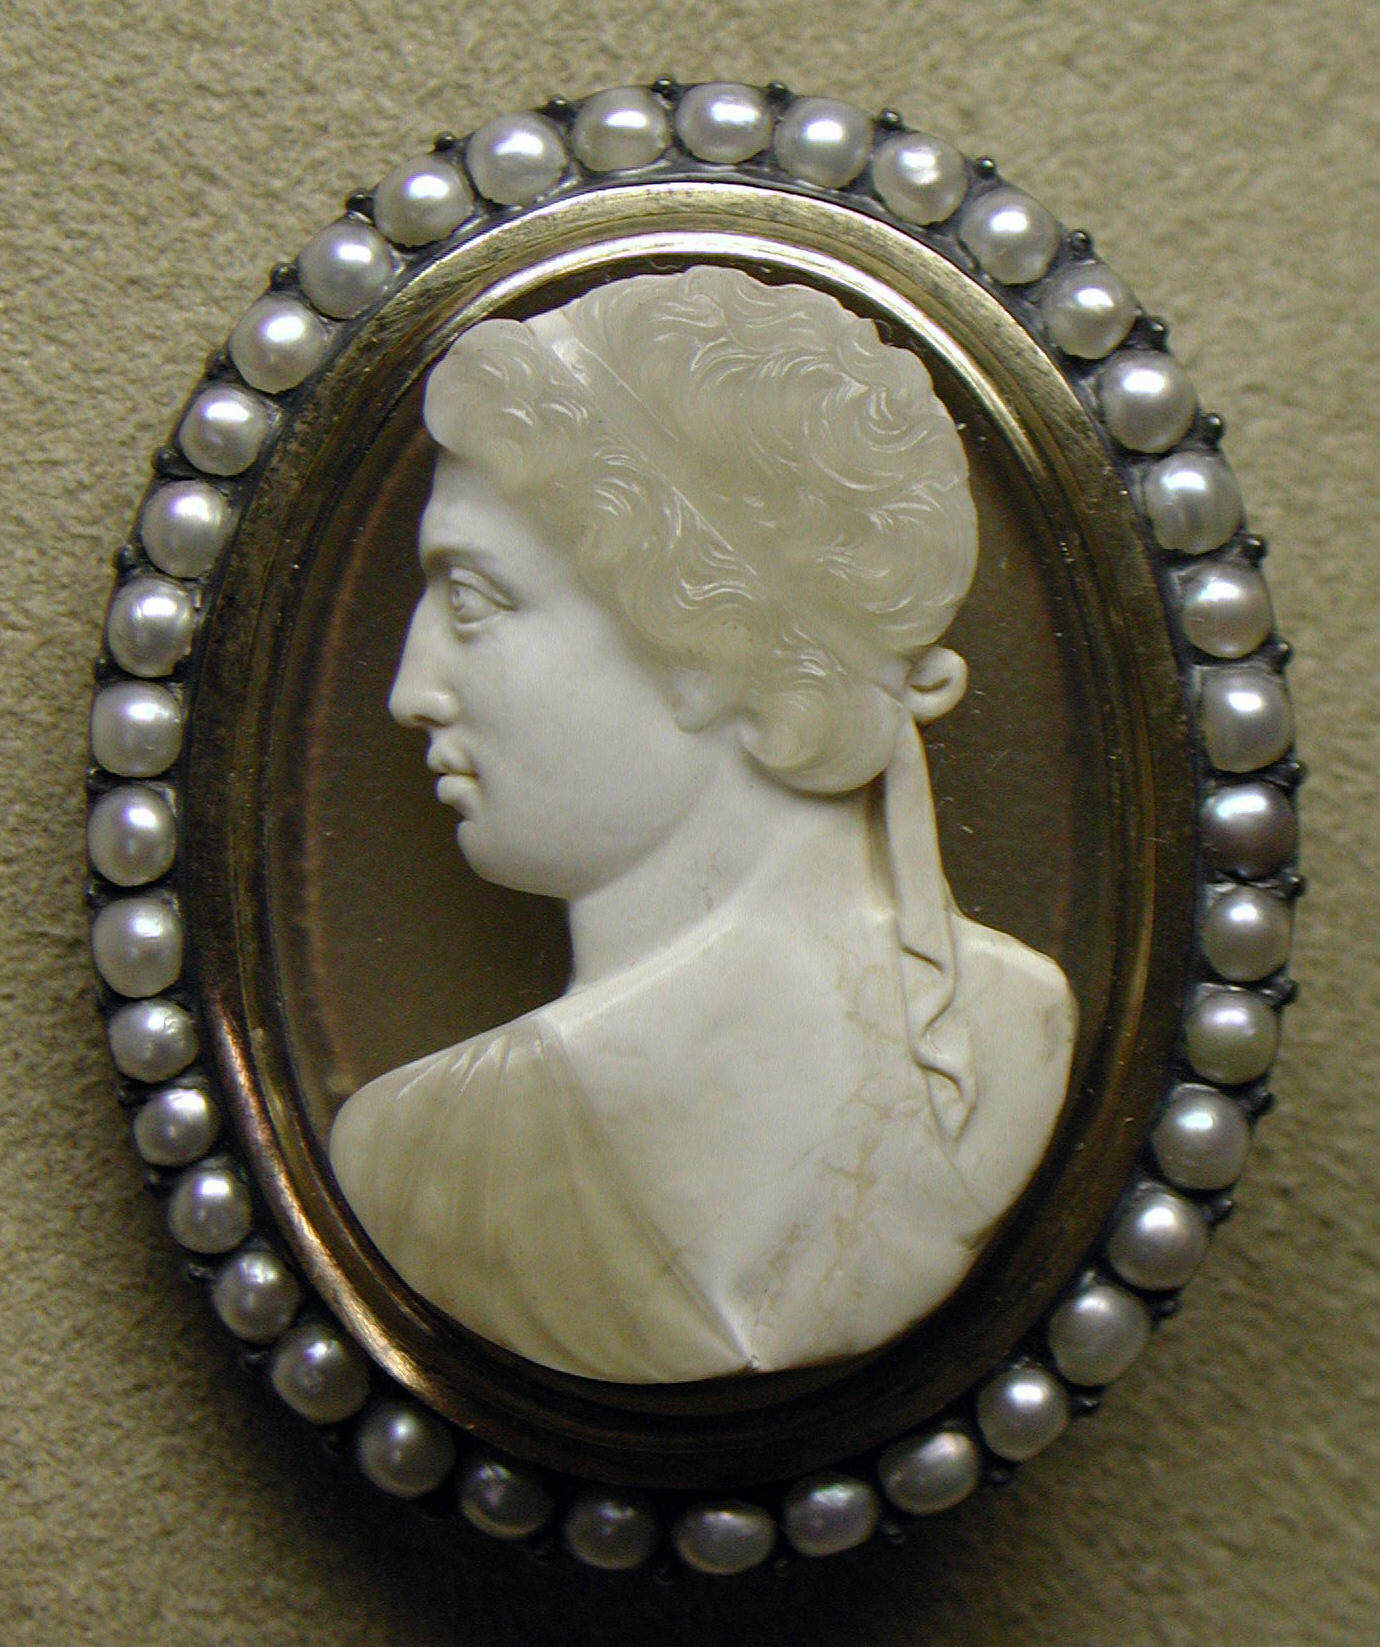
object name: cameo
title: Bust of an athlete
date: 1701-1750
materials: gold, pearl, gemstone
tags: men,profiles,athletes